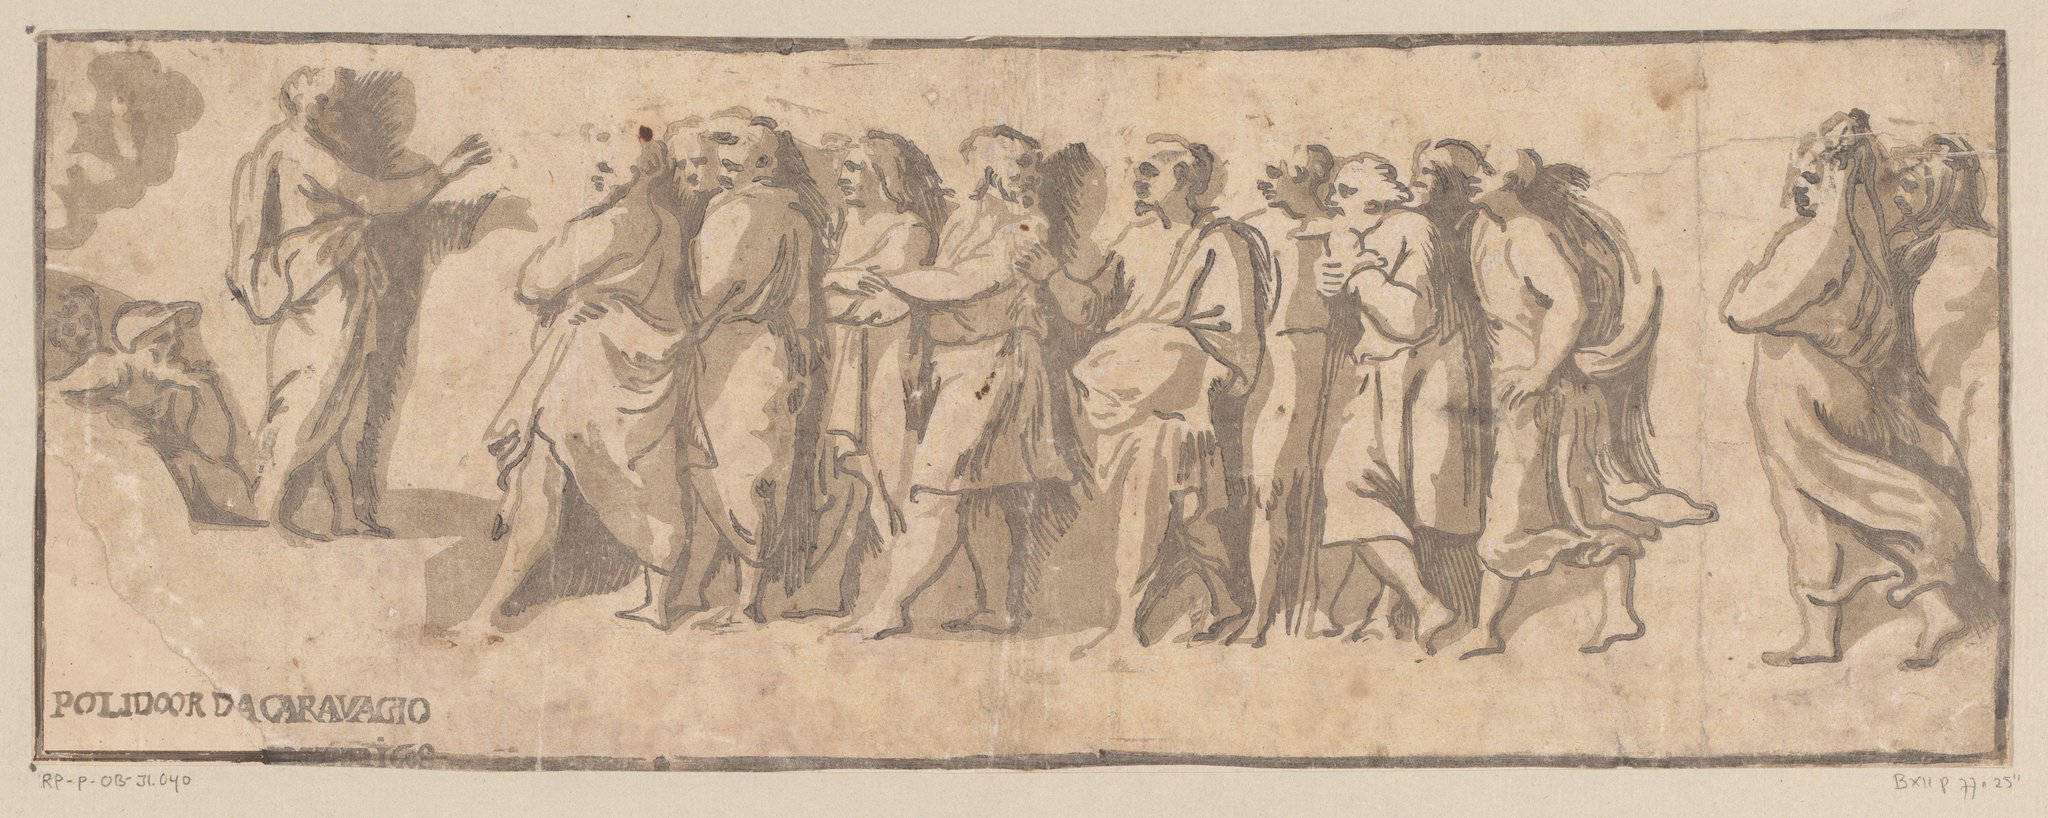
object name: print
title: Petrus preekt in Jeruzalem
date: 1608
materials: paper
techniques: woodcut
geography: italy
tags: peter delivers a sermon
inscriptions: collector's mark: Lugt 240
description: De apostel Petrus staat op een verhoging en verkondigt de boodschap van Christus. Achter hem zitten twee mannen en voor hem staan tien mannen en twee vrouwen.